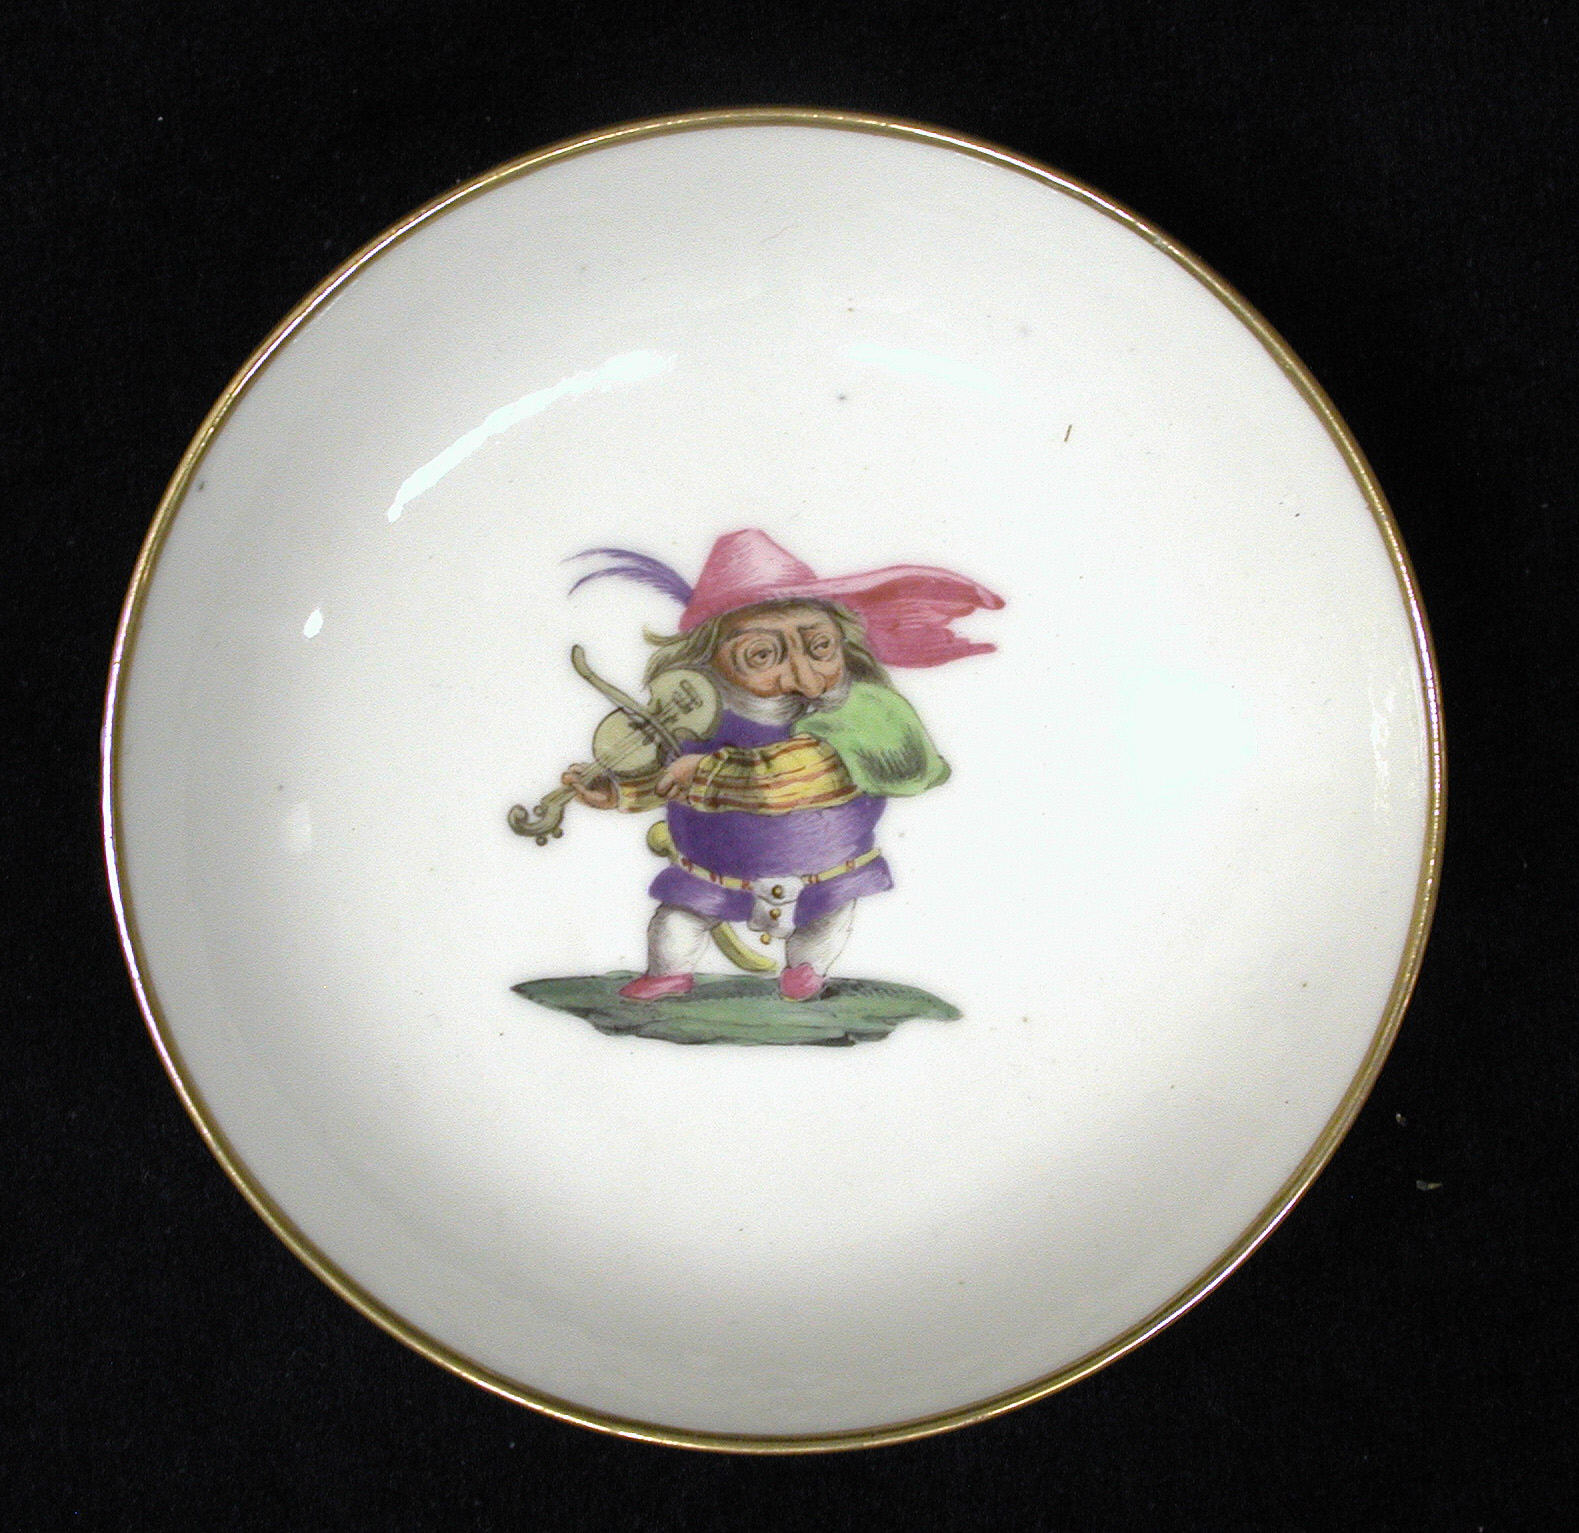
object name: saucer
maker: royal porcelain manufactory, naples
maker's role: manufactory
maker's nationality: italian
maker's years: 1759-1819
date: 1785-1795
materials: soft paste porcelain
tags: men,music,violins